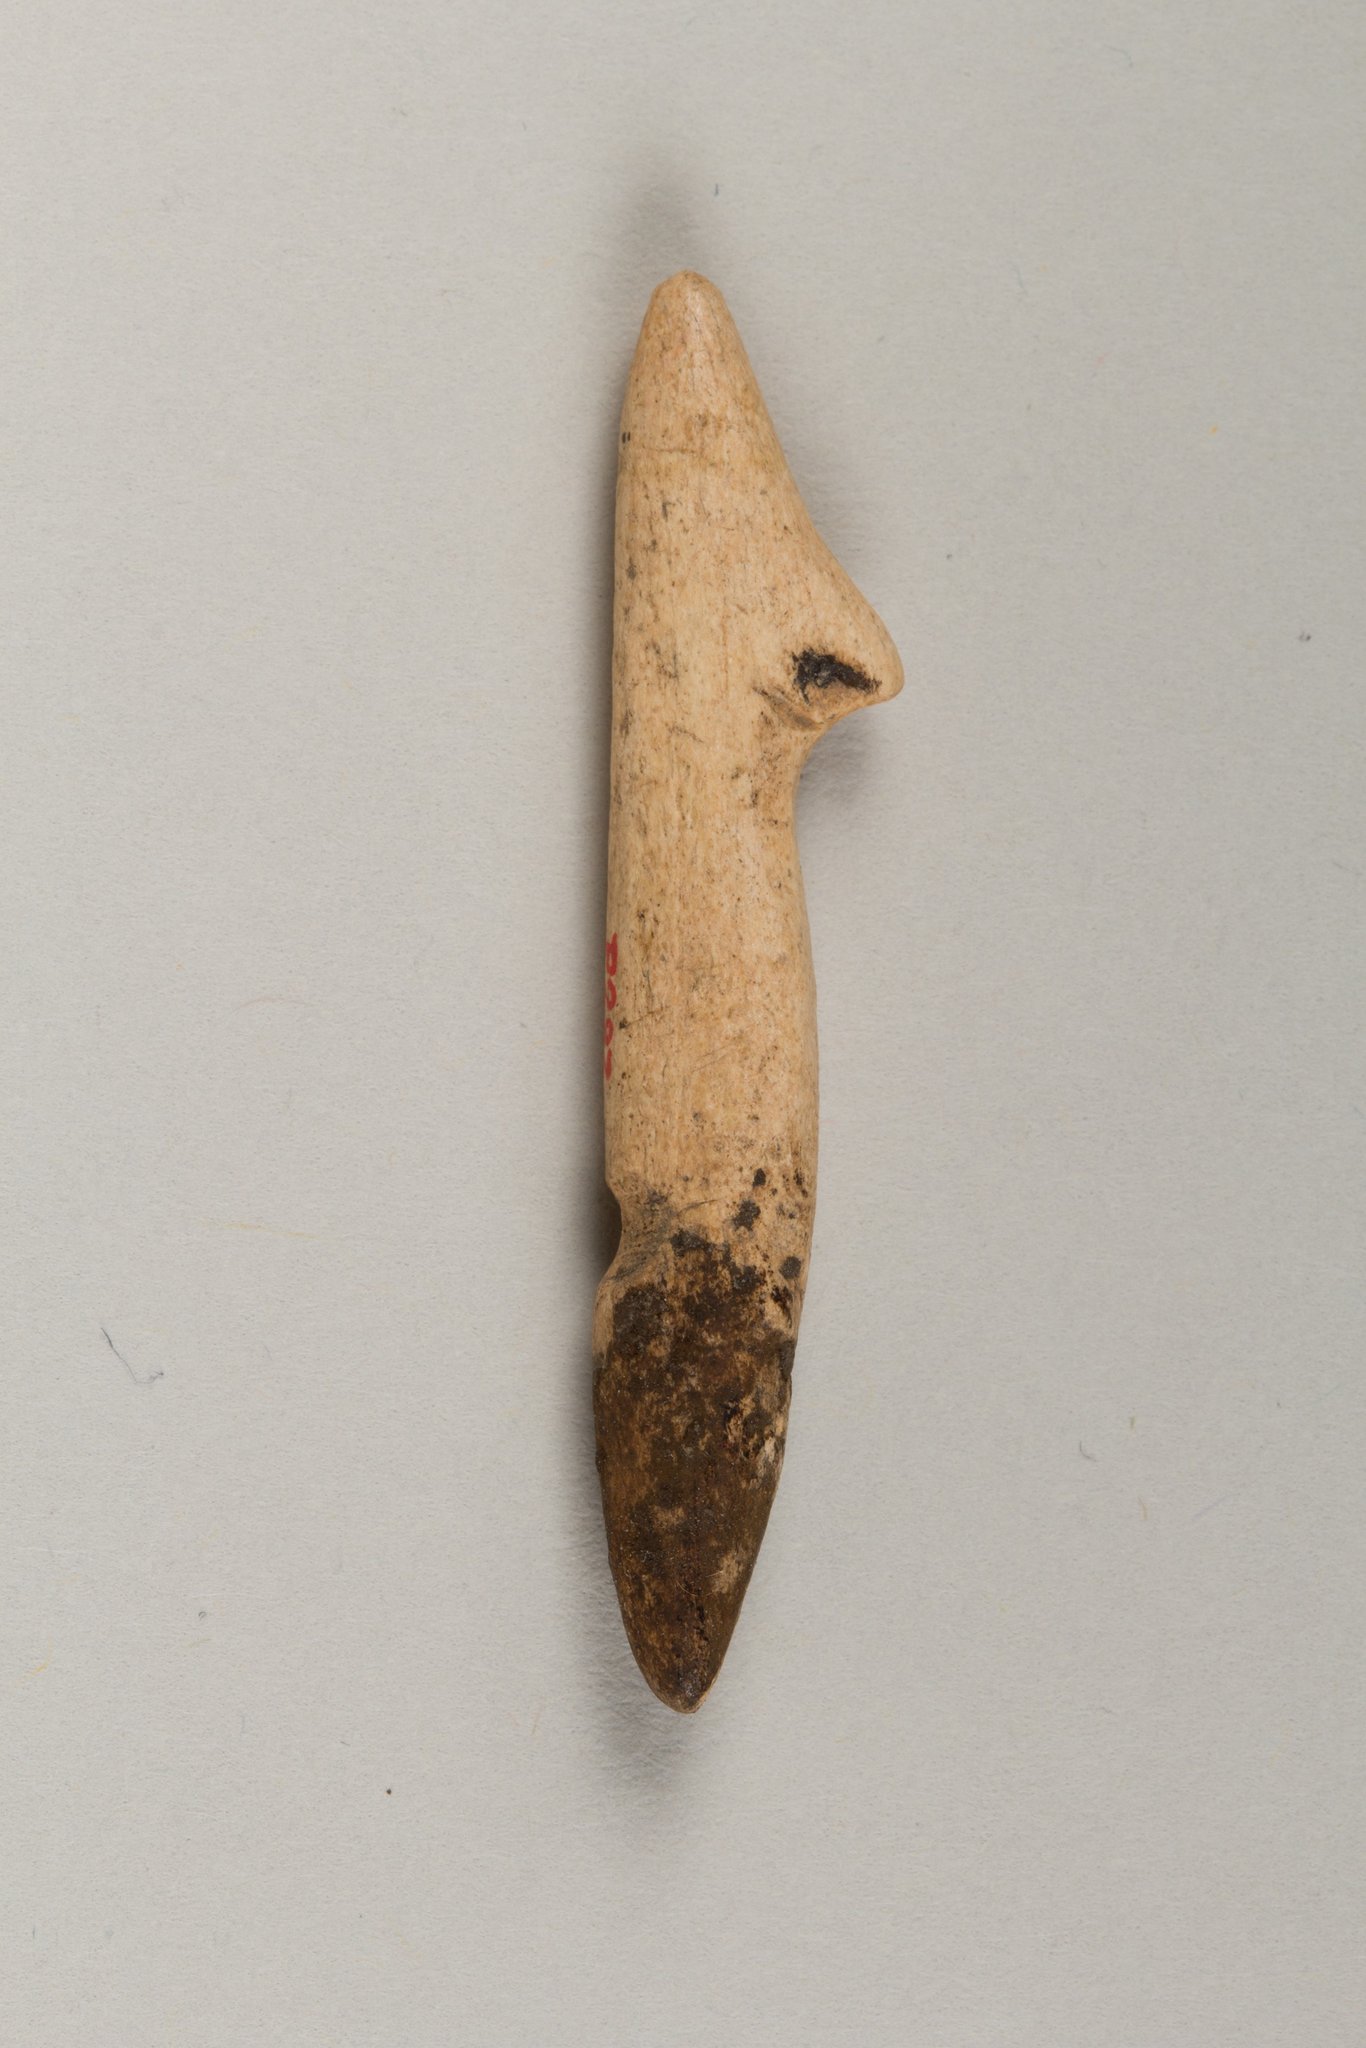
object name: harpoon head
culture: japanese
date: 1000-300 BCE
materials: bone